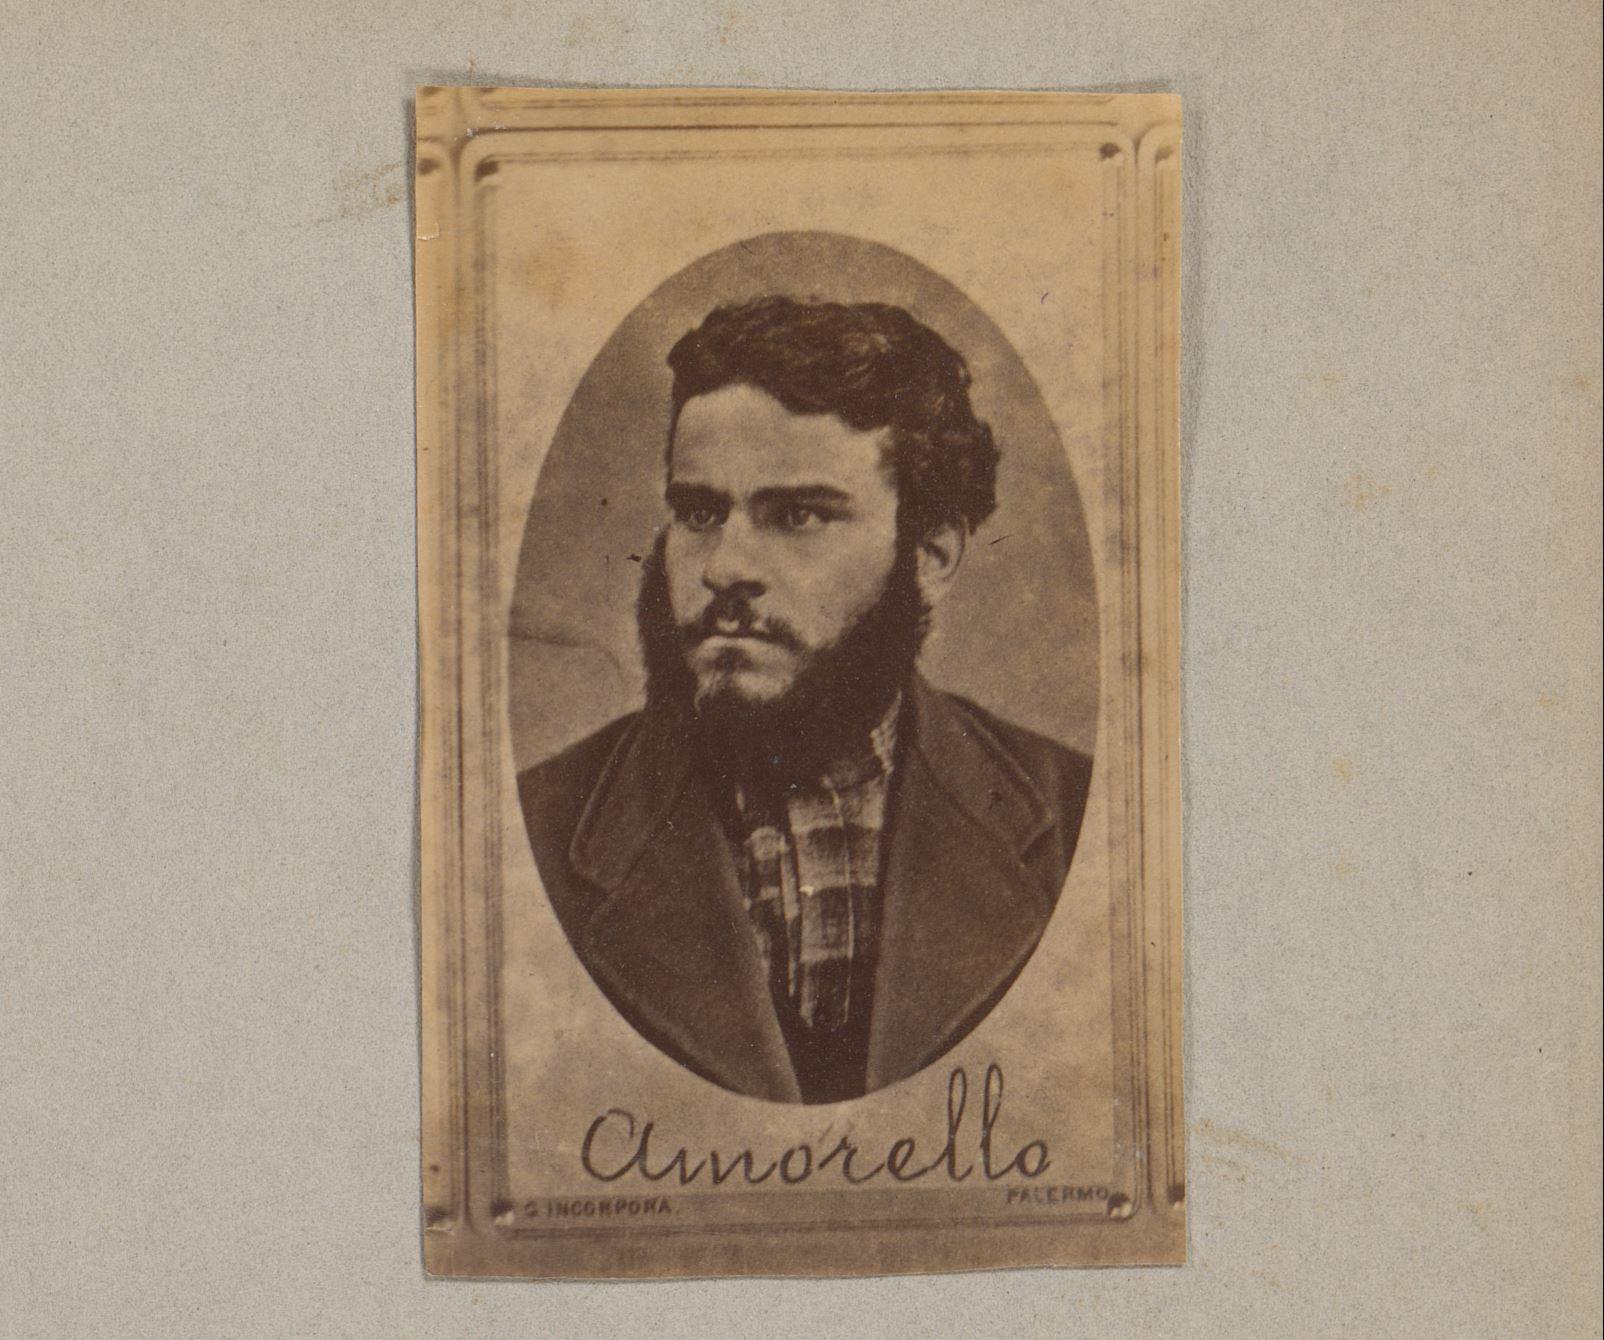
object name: reproduction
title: Fotoreproductie van een carte-de-visite van 'Amorello', Siciliaanse brigard, door Giuseppe Incorpora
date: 1887-1888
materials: paper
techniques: albumen print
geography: palermo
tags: adult man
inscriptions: inscription: ‘6 Brigards de Sicilie capturés en 1878/ exécutés en 1880 à Palerme./ (Reproductie vergr. pl. Monckhoven 8 sec.)’, inscription: ‘Amorello/ G. Incorpora/ Palermo’